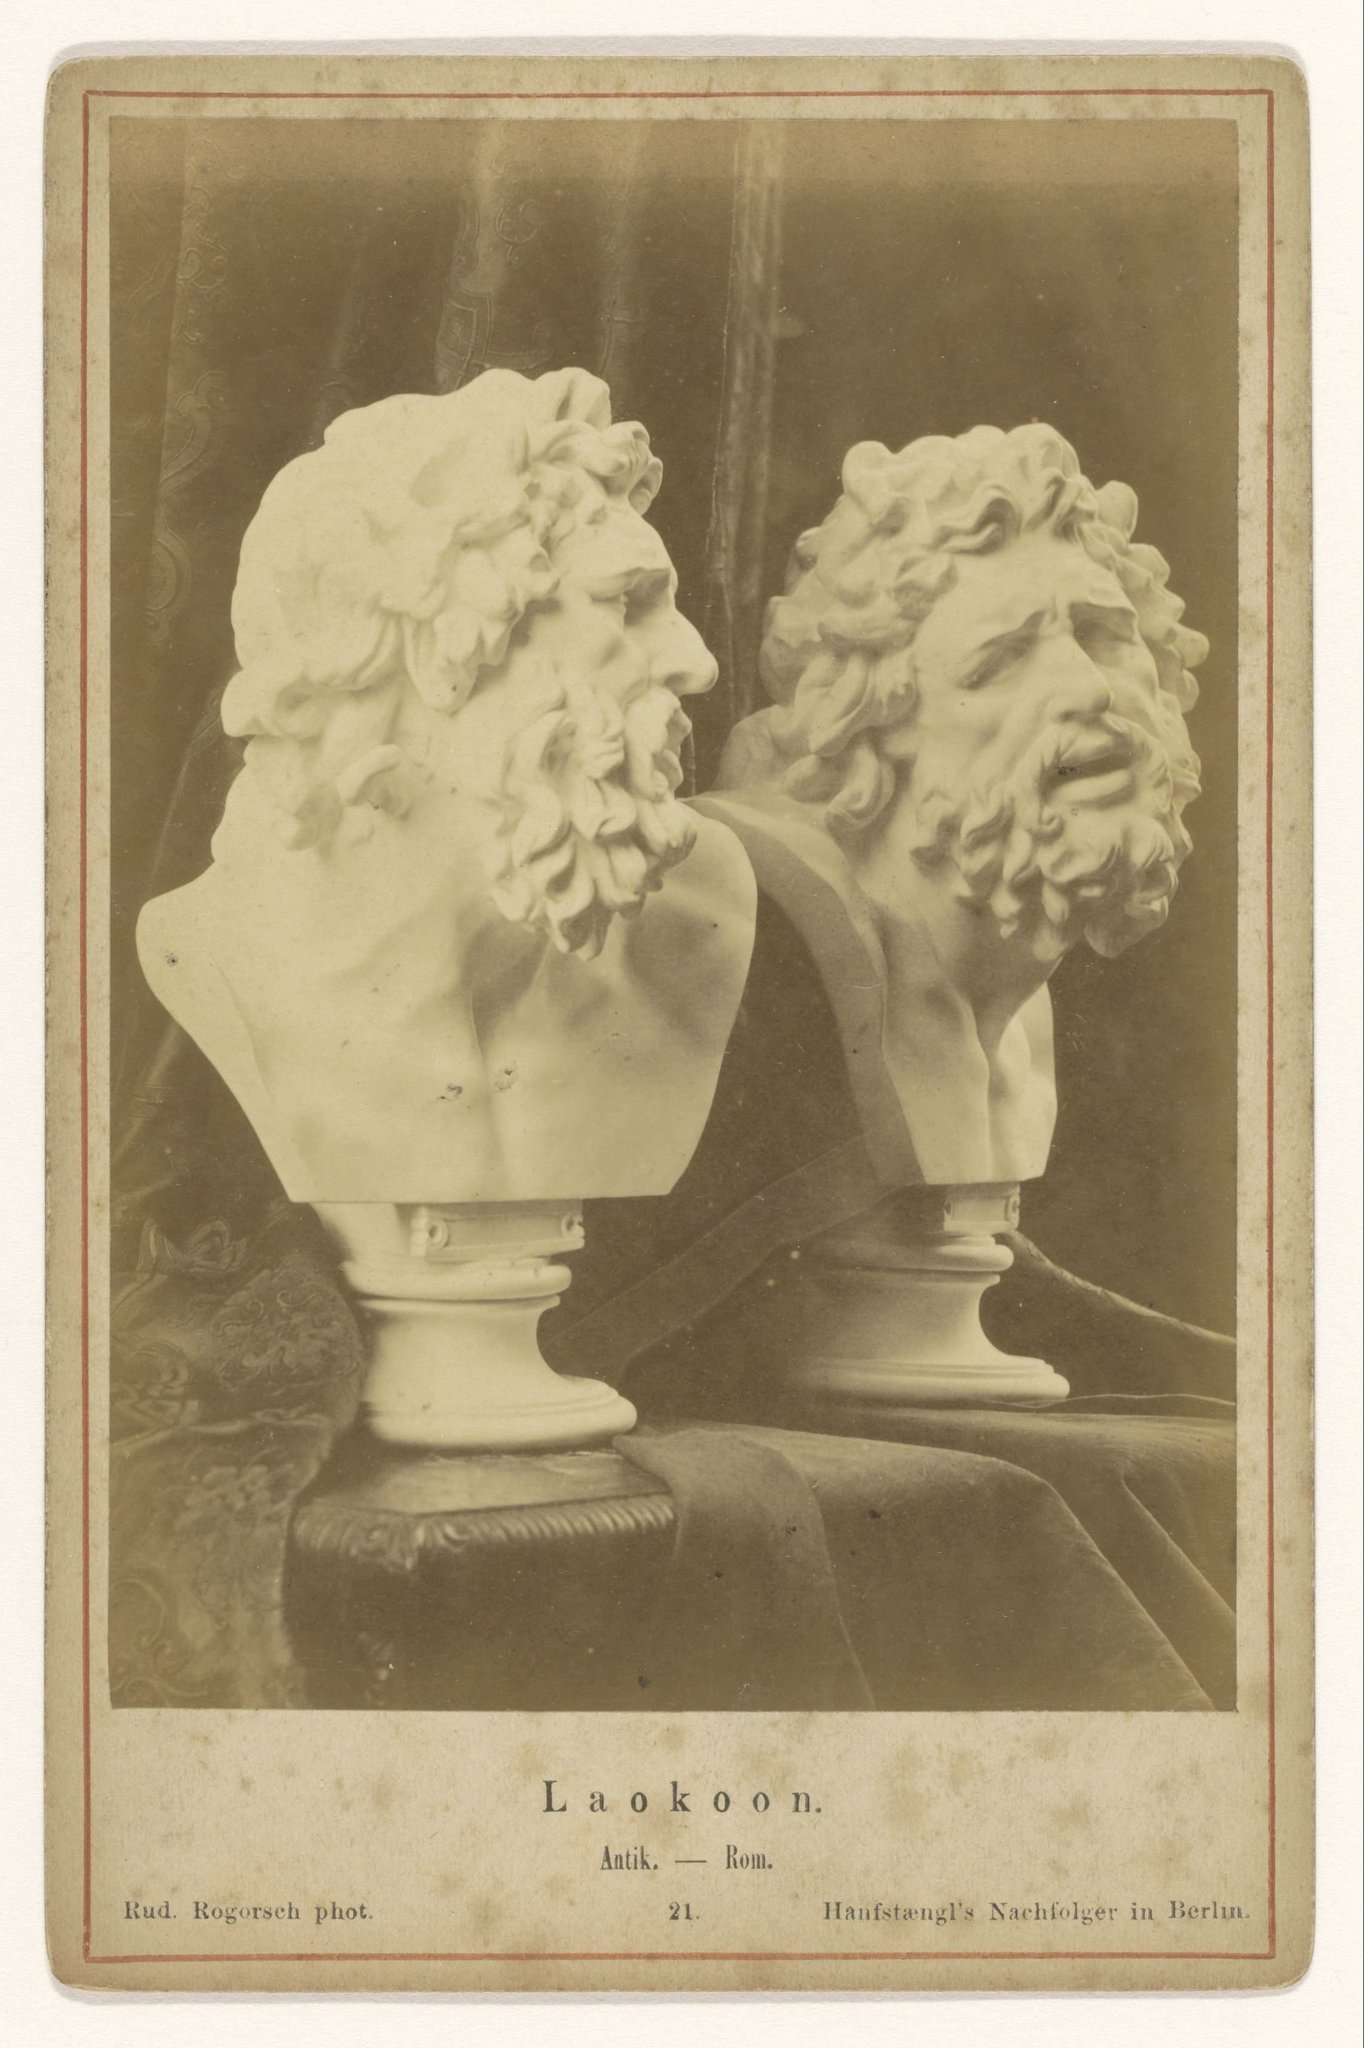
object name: photograph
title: Sculptuur van het hoofd van Laocoön, met spiegelbeeld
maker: rudolph rogorsch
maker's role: fotograaf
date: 1866-1880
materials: cardboard, paper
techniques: albumen print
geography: berlin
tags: laocoon and his twin sons are strangled by two serpents during the preparations for a sacrifice, piece of sculpture, reproduction of a piece of sculpture, berlin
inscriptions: collector's mark: ‘Vosmaer’, inscription: ‘Laokoon./ Antik. - Rom./ 21./ Rud. Rogorsch phot. Hanfstaengl's Nachfolger in Berlin.’